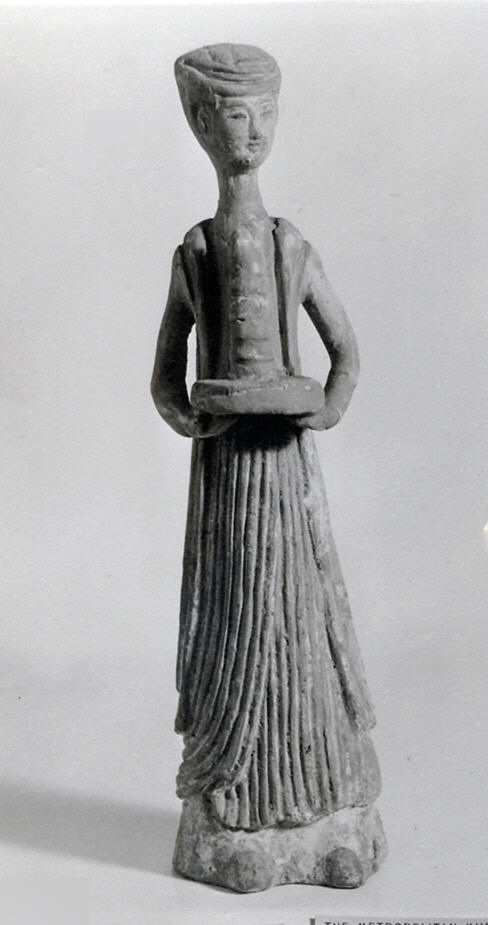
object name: figure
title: Female musician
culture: chinese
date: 501-600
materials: earthenware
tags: women